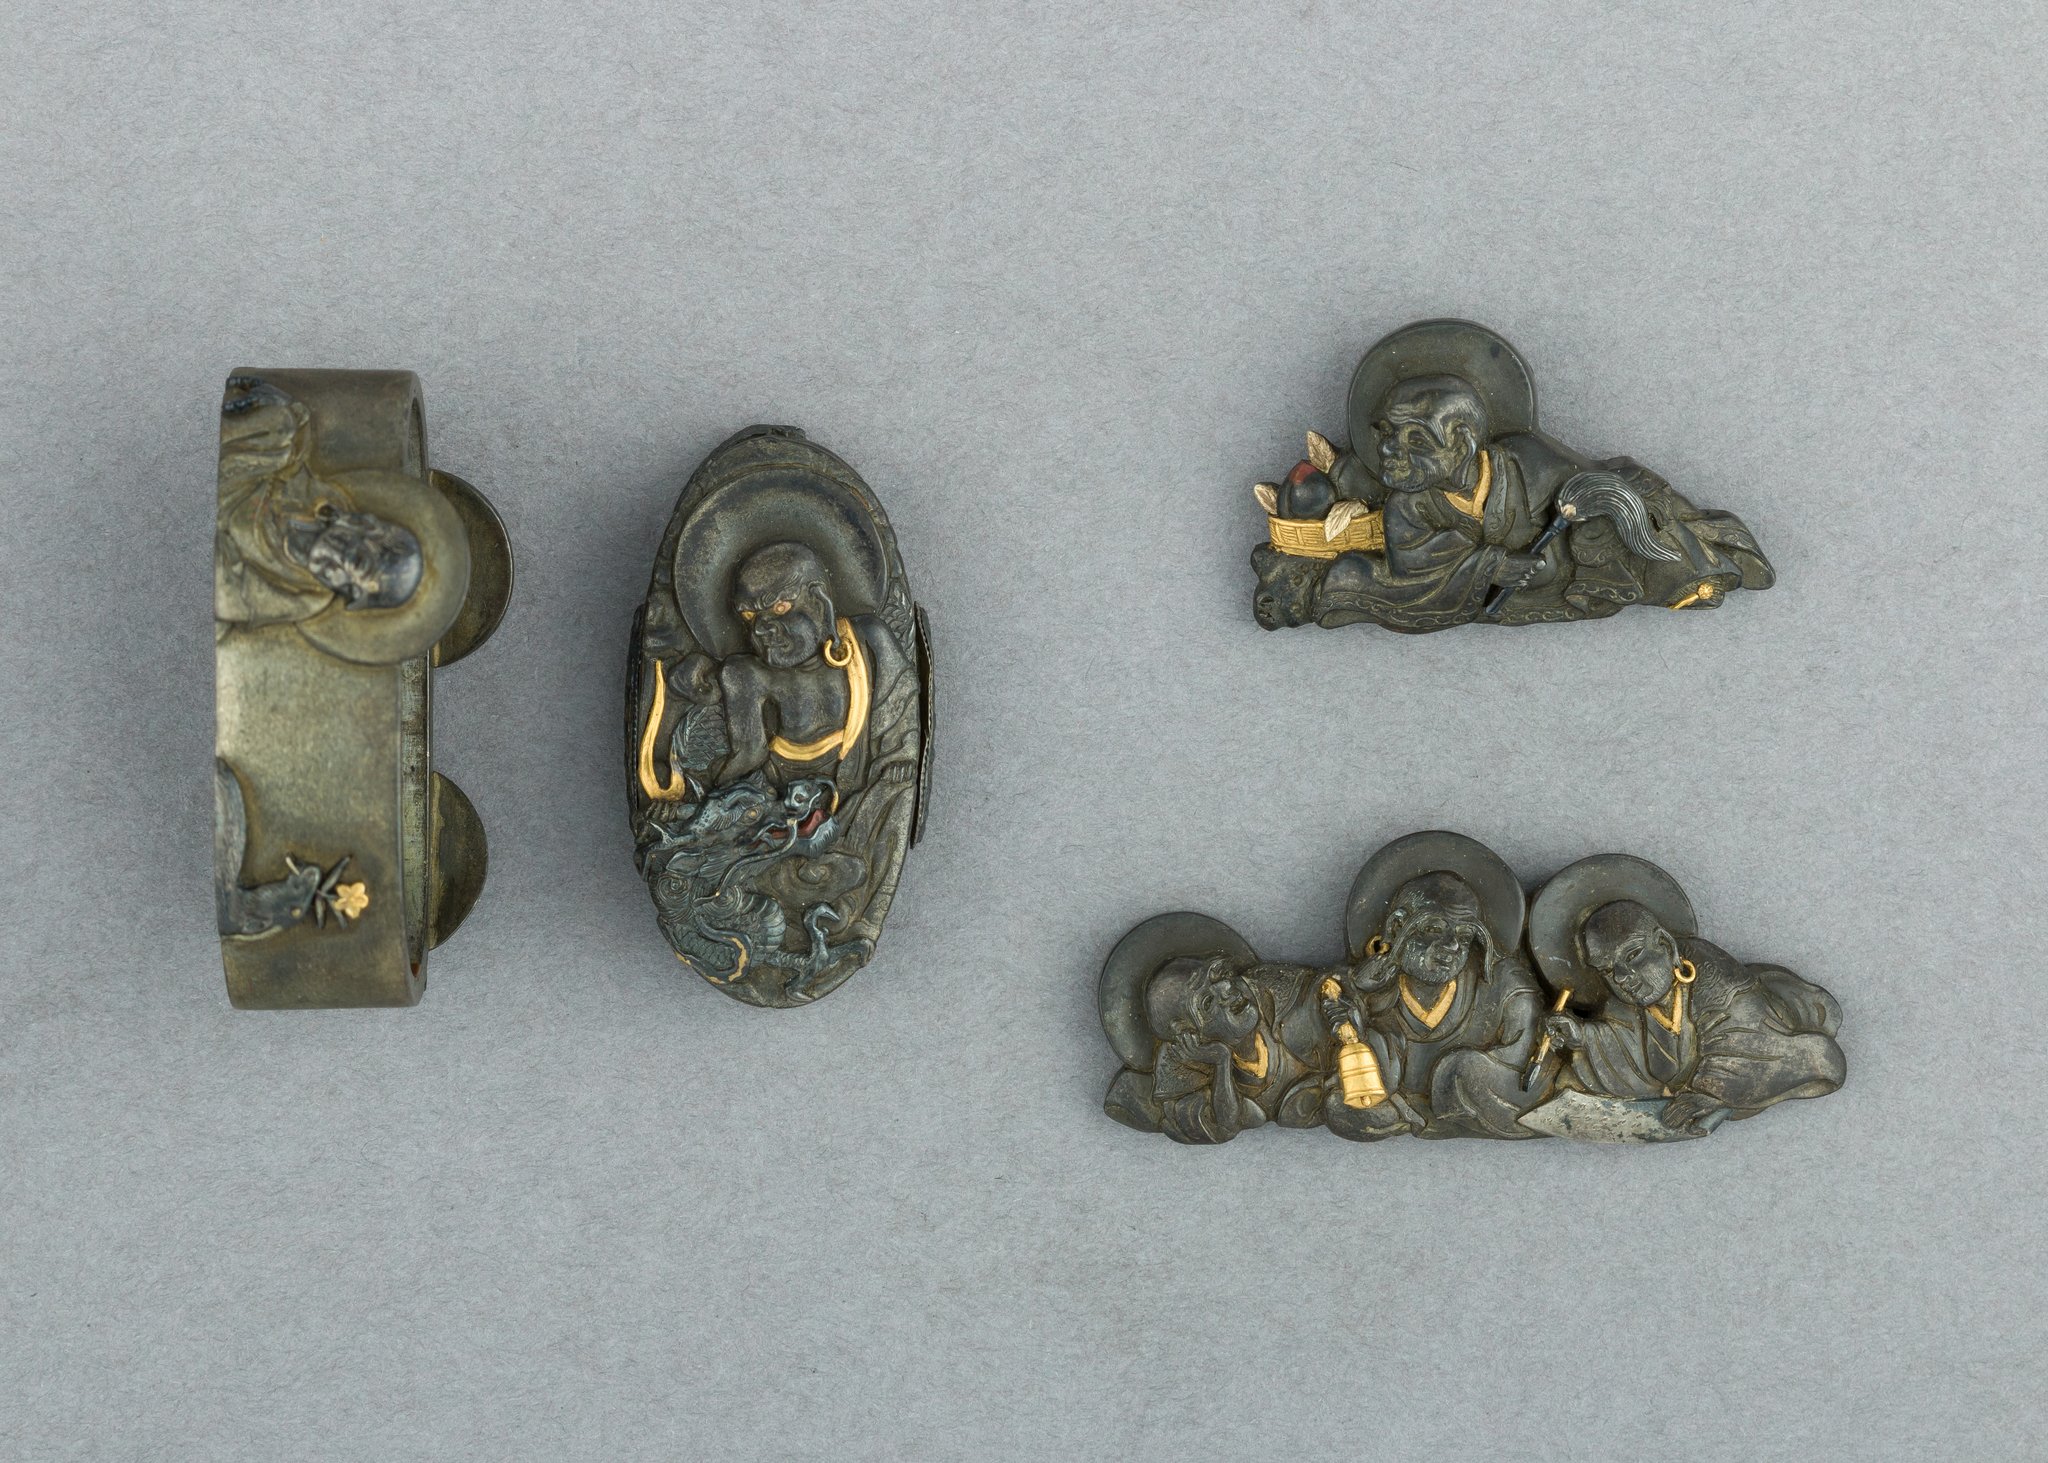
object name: sword hilt washer and pommel fuchigashira and pair of grip ornament menuki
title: Set of Sword Fittings (Mitokoromono)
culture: japanese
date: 1615-1868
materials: copper, gold alloy, silver alloy, gold, silver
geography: japan